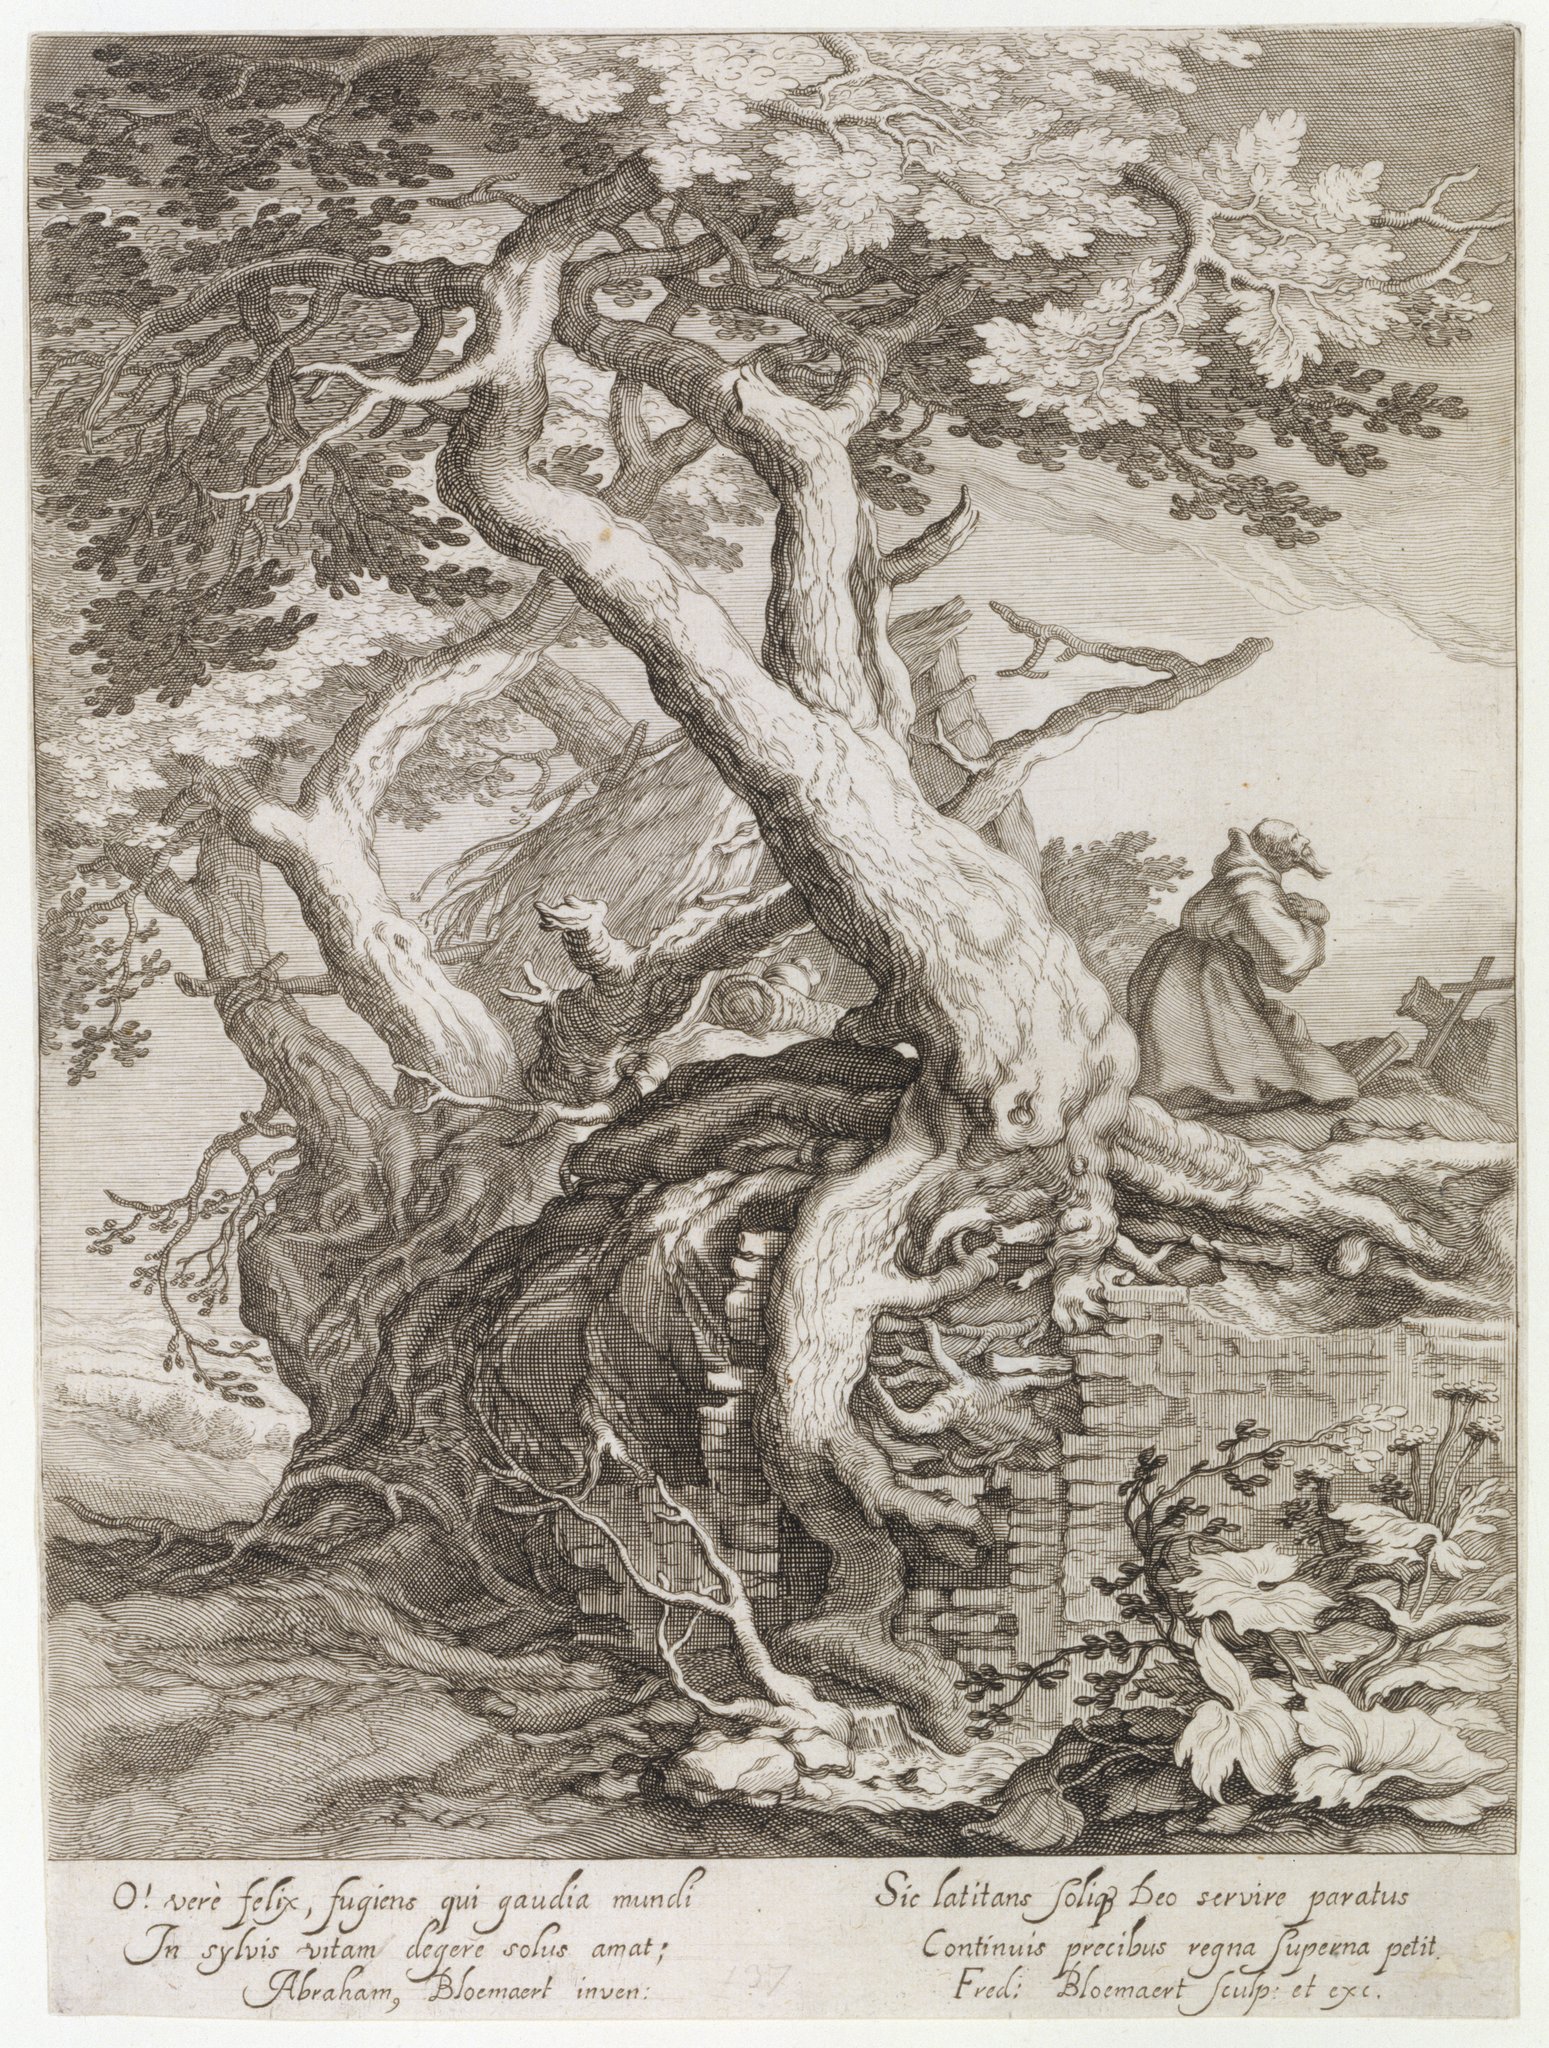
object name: print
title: Landscape with a Hermit Praying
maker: frederick bloemaert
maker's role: artist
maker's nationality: dutch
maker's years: 1610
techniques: engraving